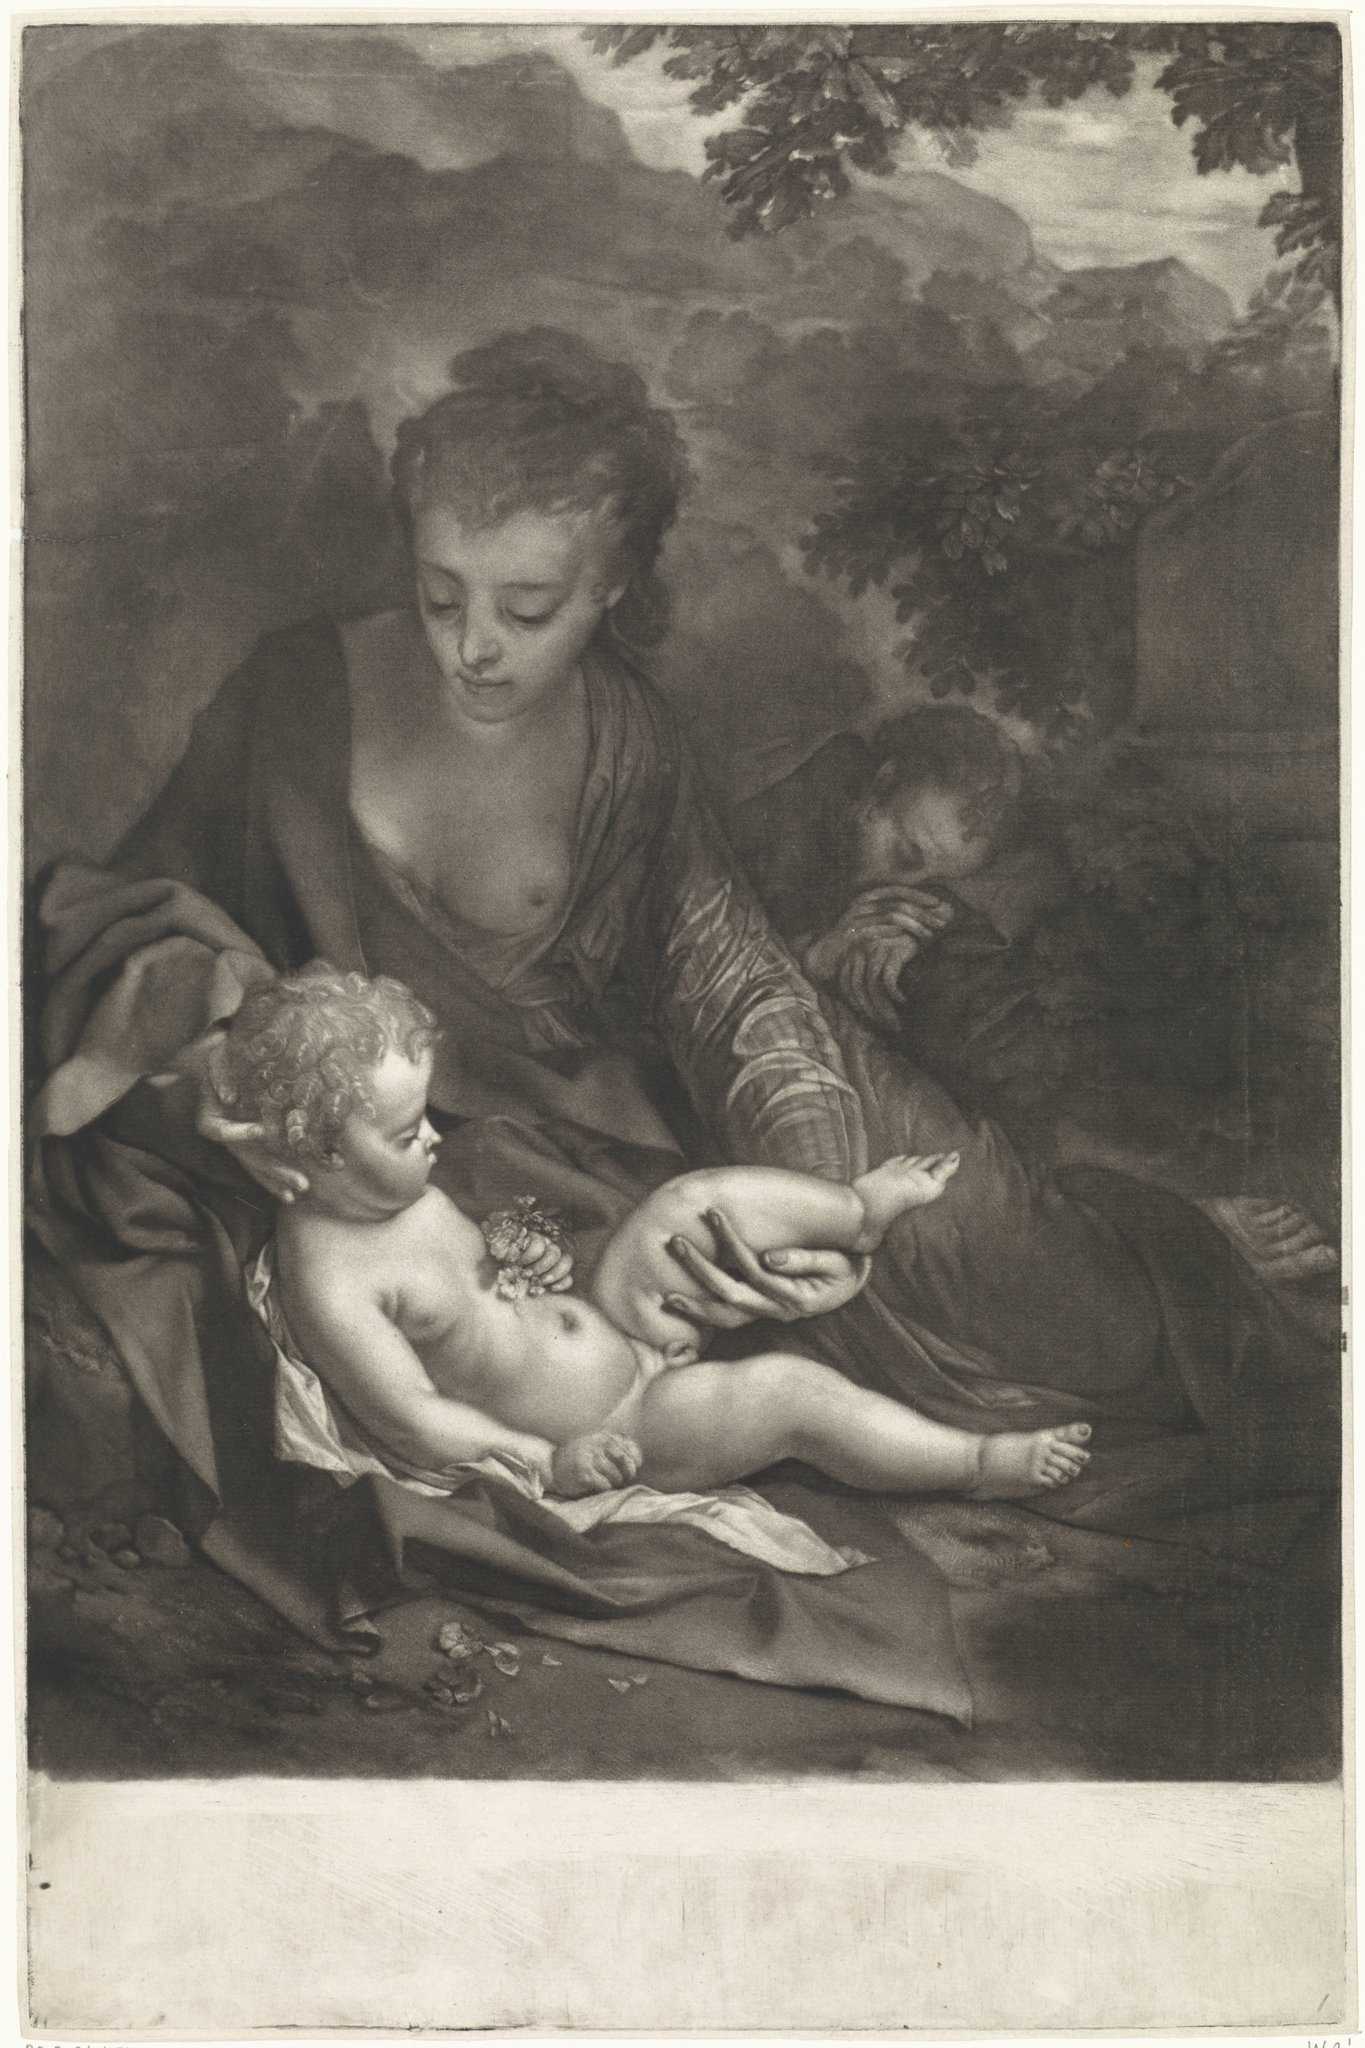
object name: print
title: Rest on the Flight into Egypt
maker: pieter van bleeck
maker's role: print maker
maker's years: 1700-1764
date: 1748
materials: paper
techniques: mezzotint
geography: england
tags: rest on the flight into egypt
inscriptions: collector's mark: Lugt 240, :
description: De Heilige Familie rust in een landschap onder een boom. Maria legt het slapende Christuskind op een doek. Op de achtergrond zit Jozef te slapen.